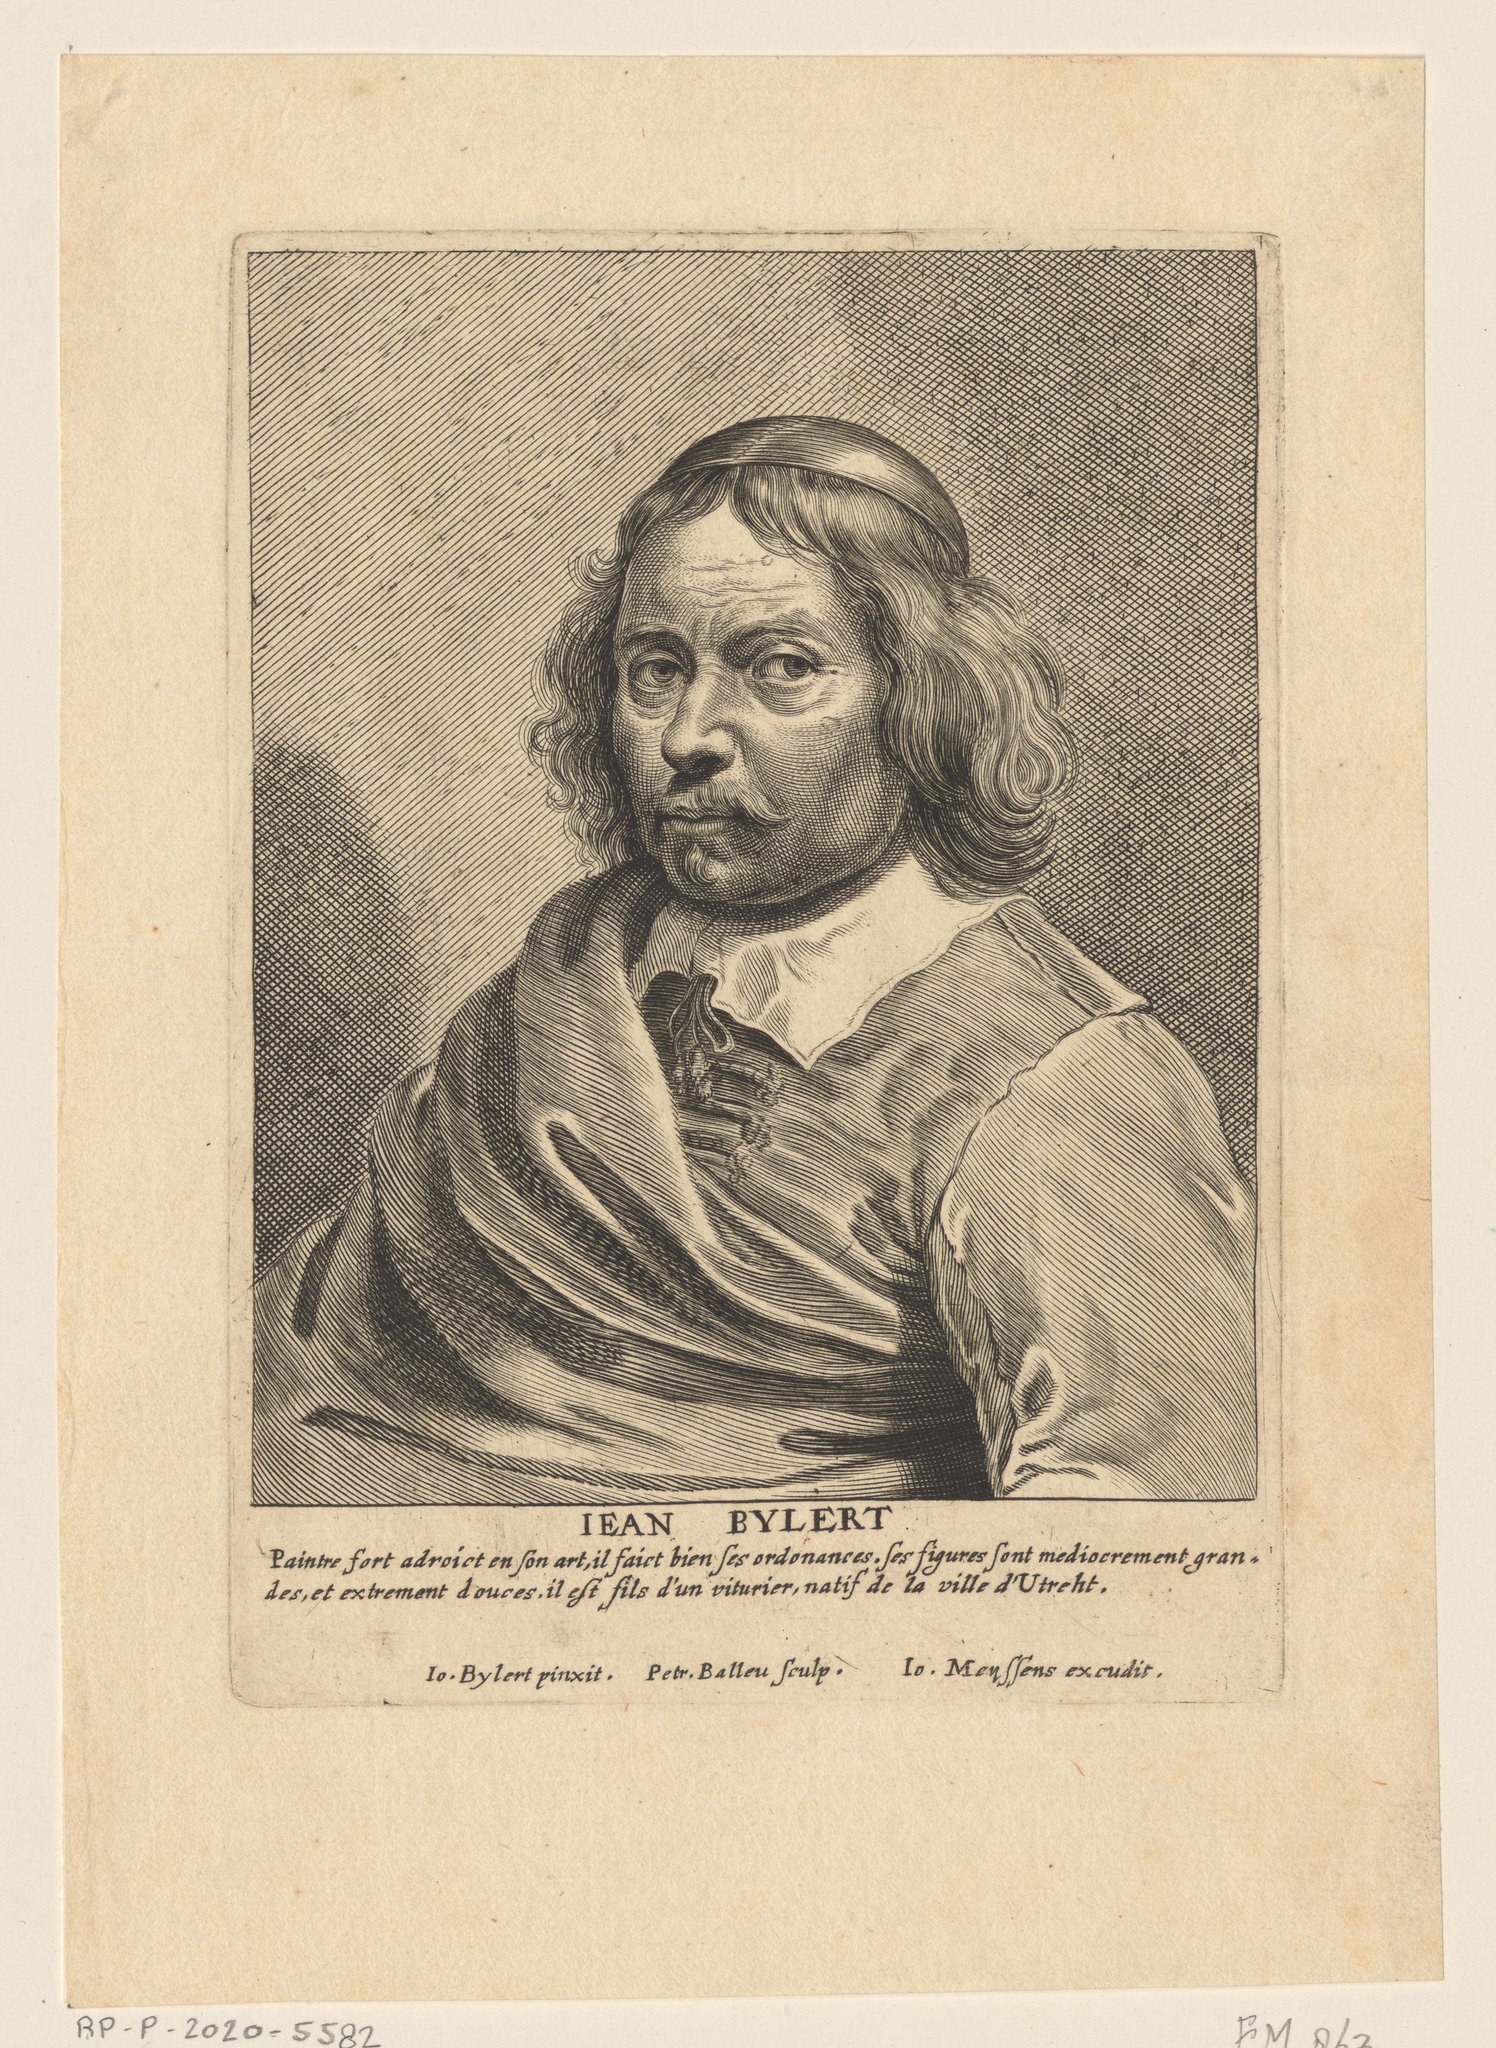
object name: print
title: Image de divers hommes desprit sublime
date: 1649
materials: paper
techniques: engraving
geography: antwerp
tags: utrecht, painter, jan van bijlert, historical persons, portrait, self-portrait of painter